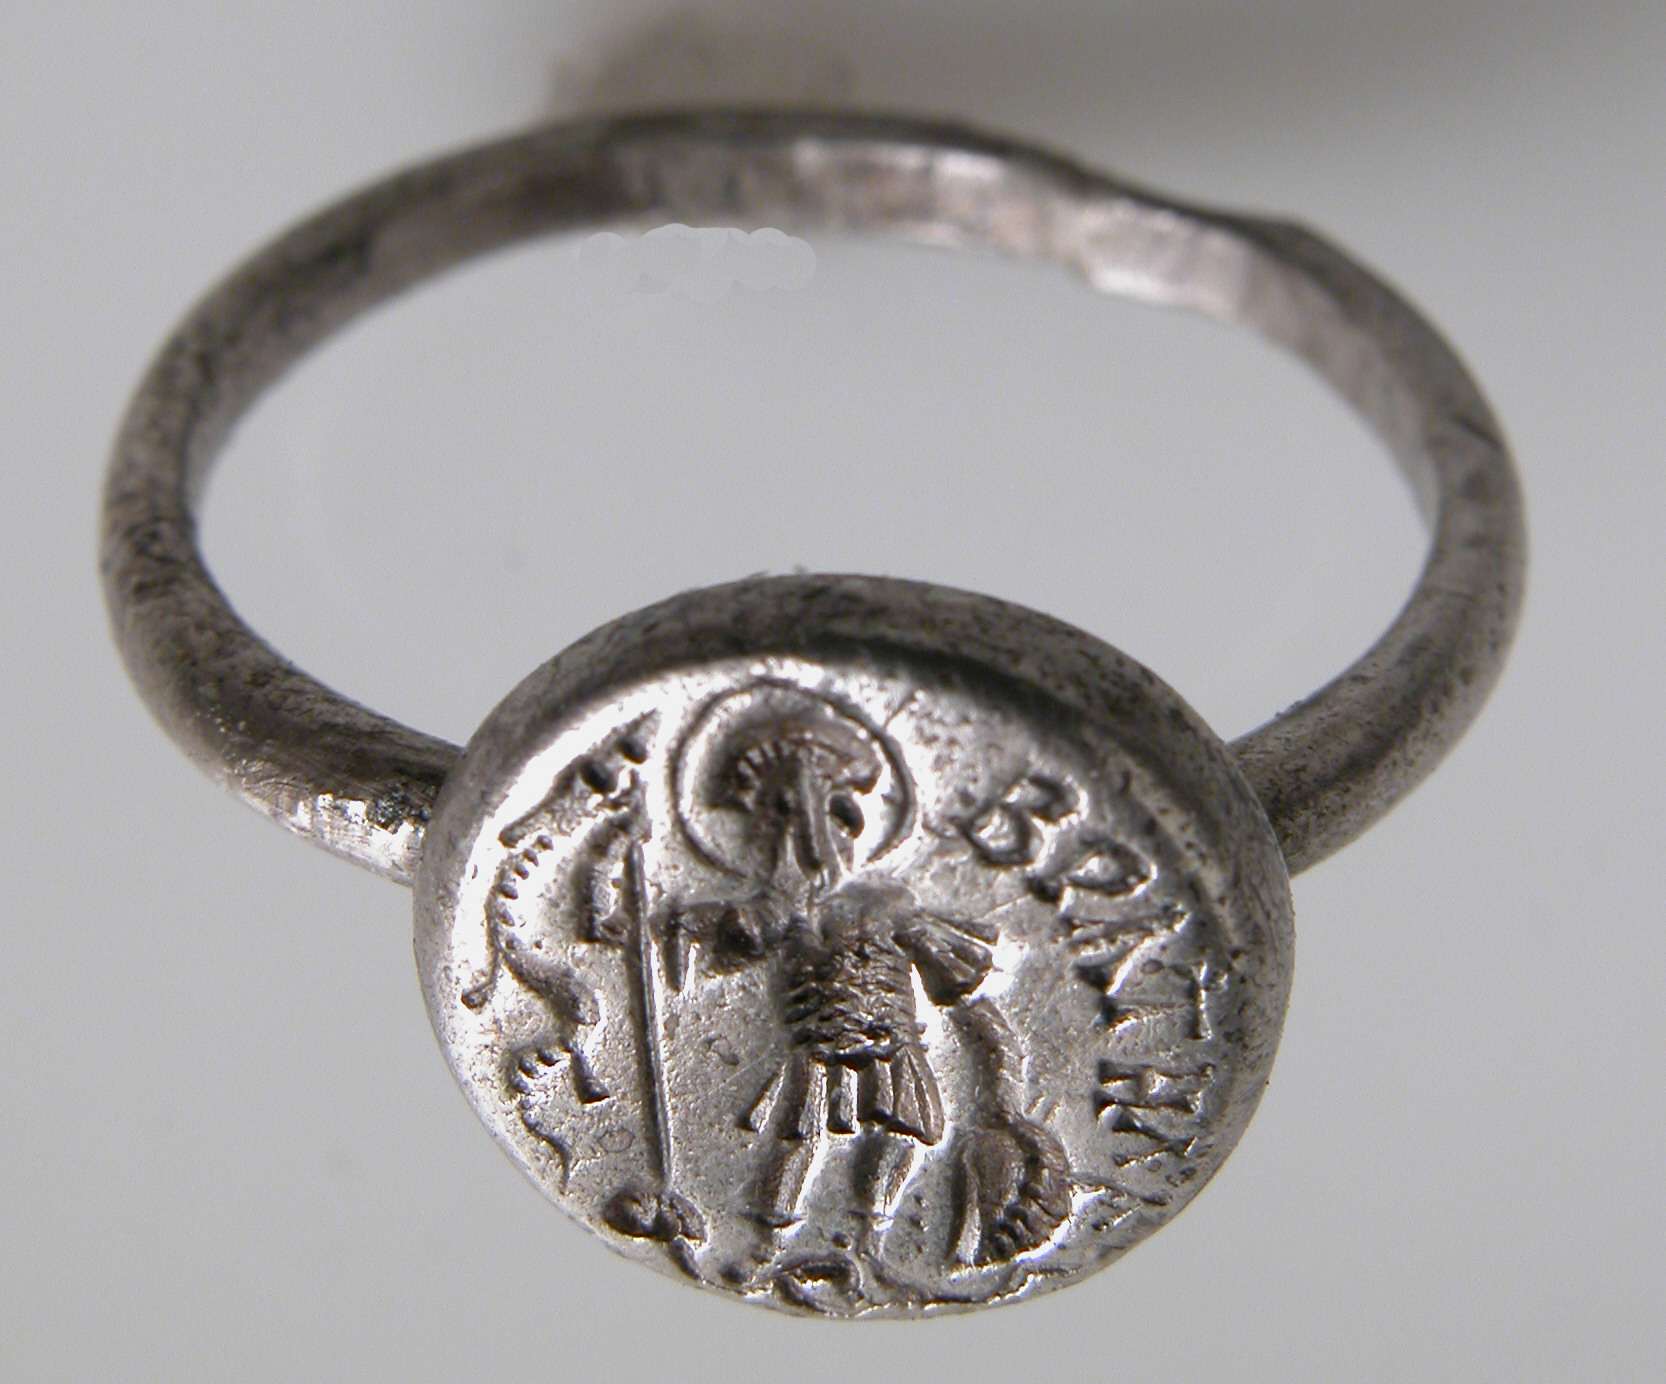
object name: ring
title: Seal Ring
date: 401-600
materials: silver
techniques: carving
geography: egypt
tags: spears,dragons,warriors